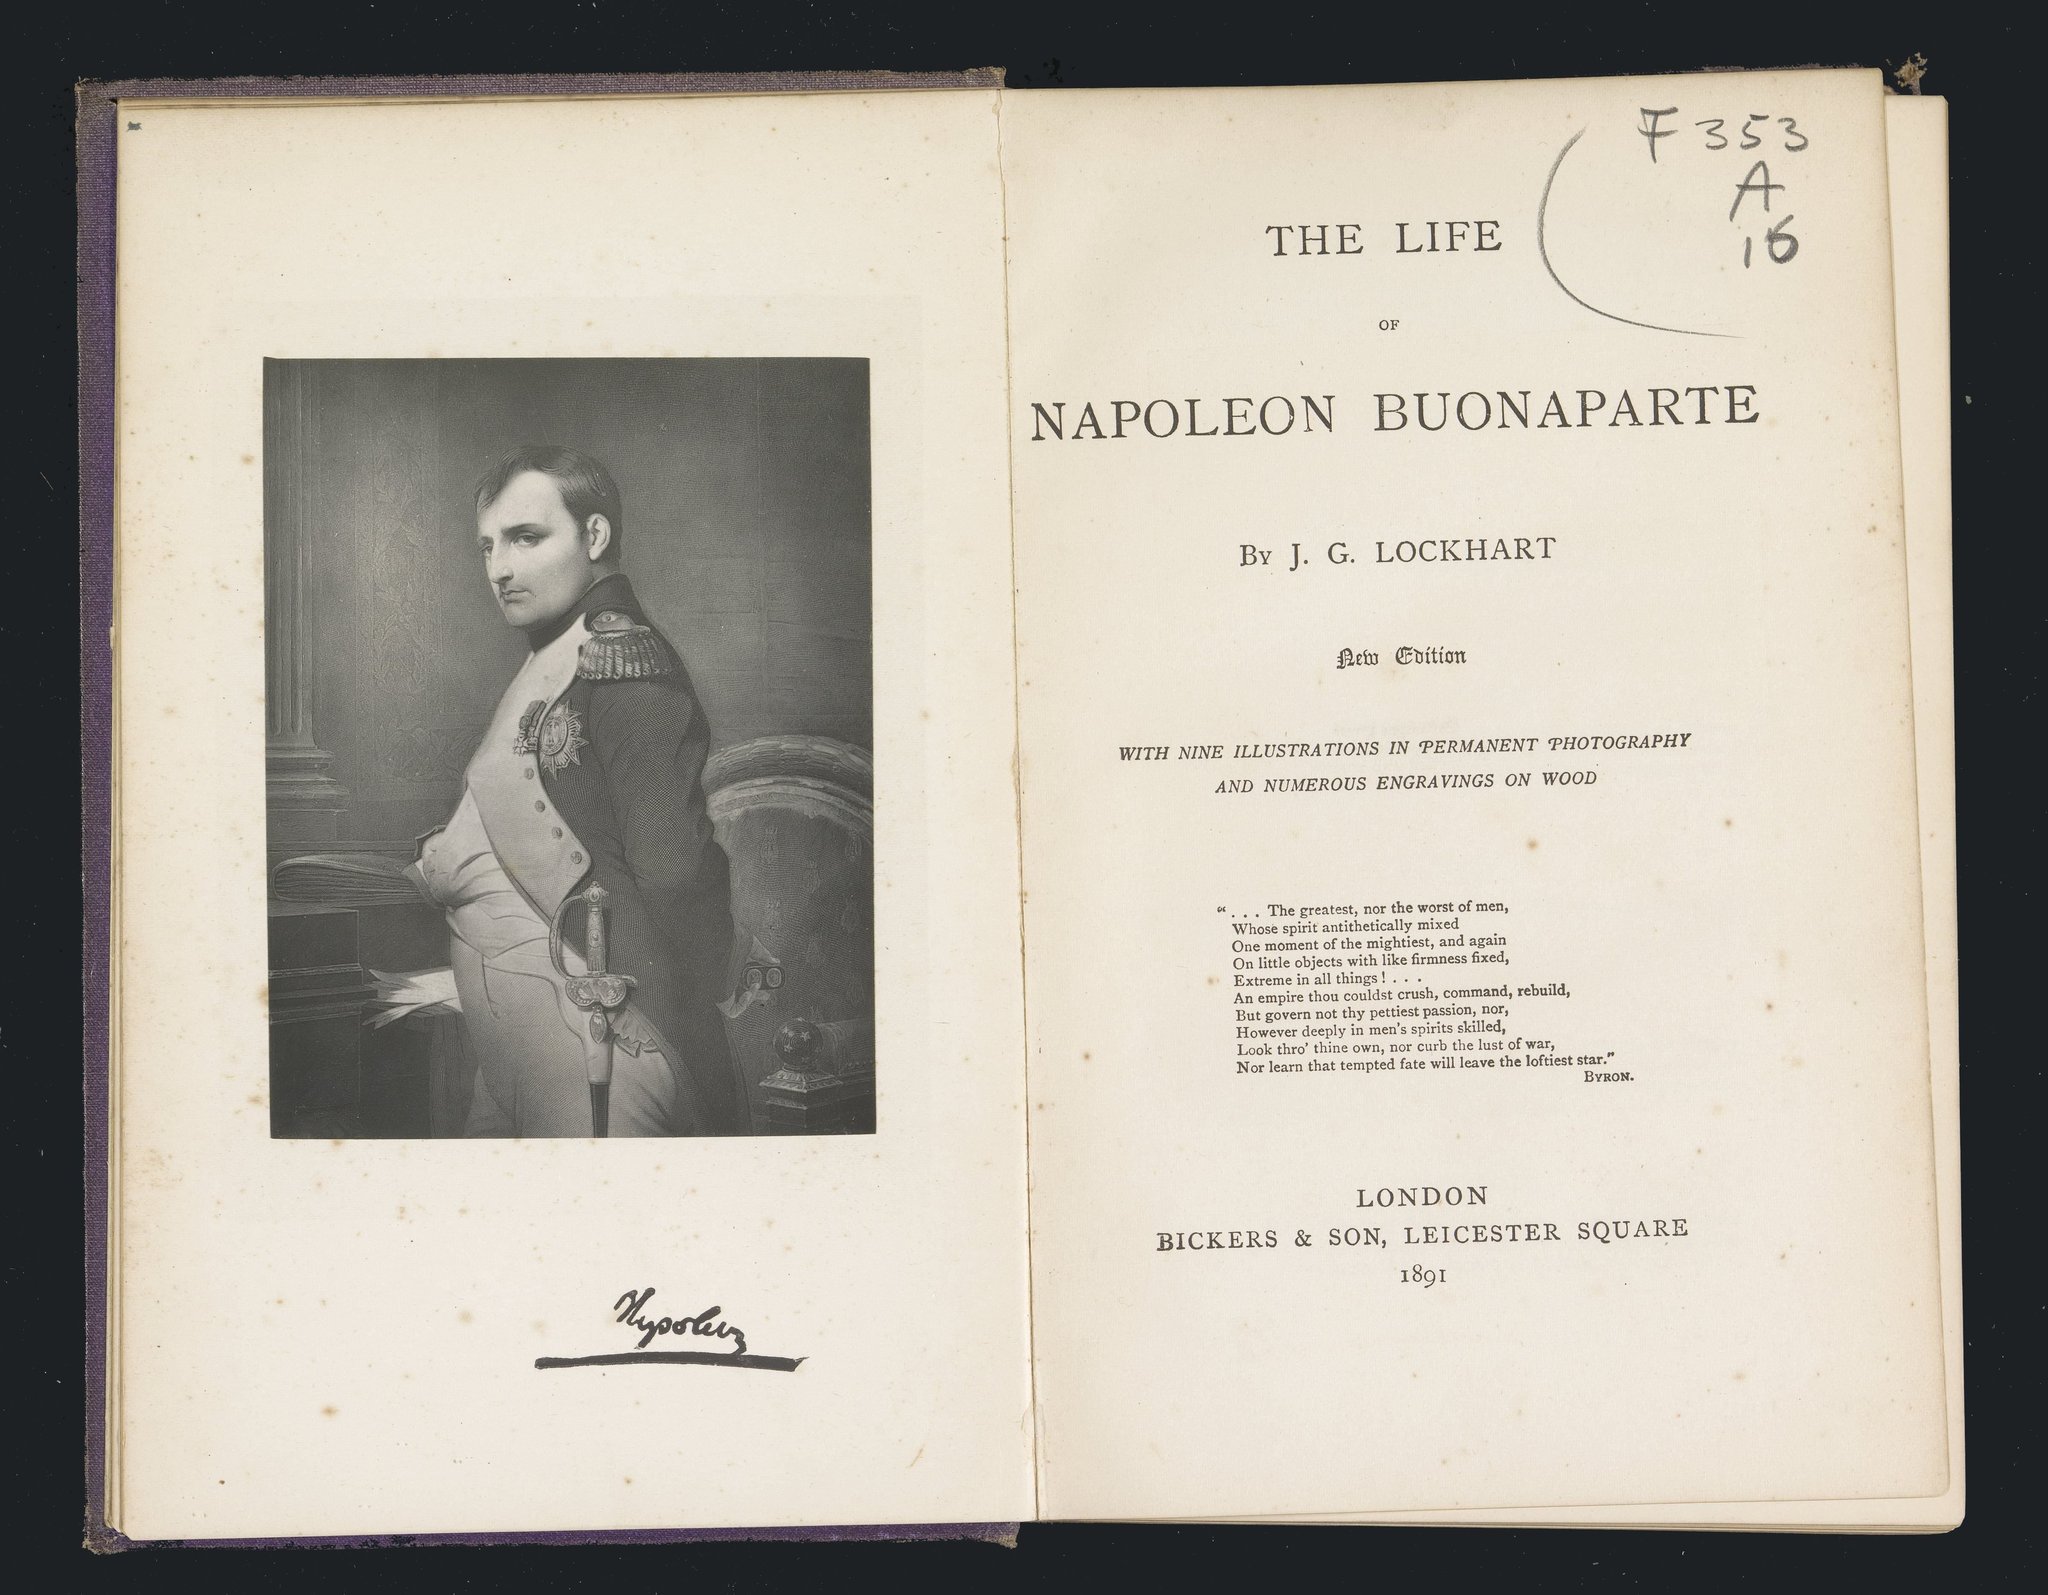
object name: photograph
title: Napoleon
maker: Anonymous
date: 1880-1891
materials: photographic support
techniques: gelatin silver print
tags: napoleon i (emperor of the french), ruler, sovereign